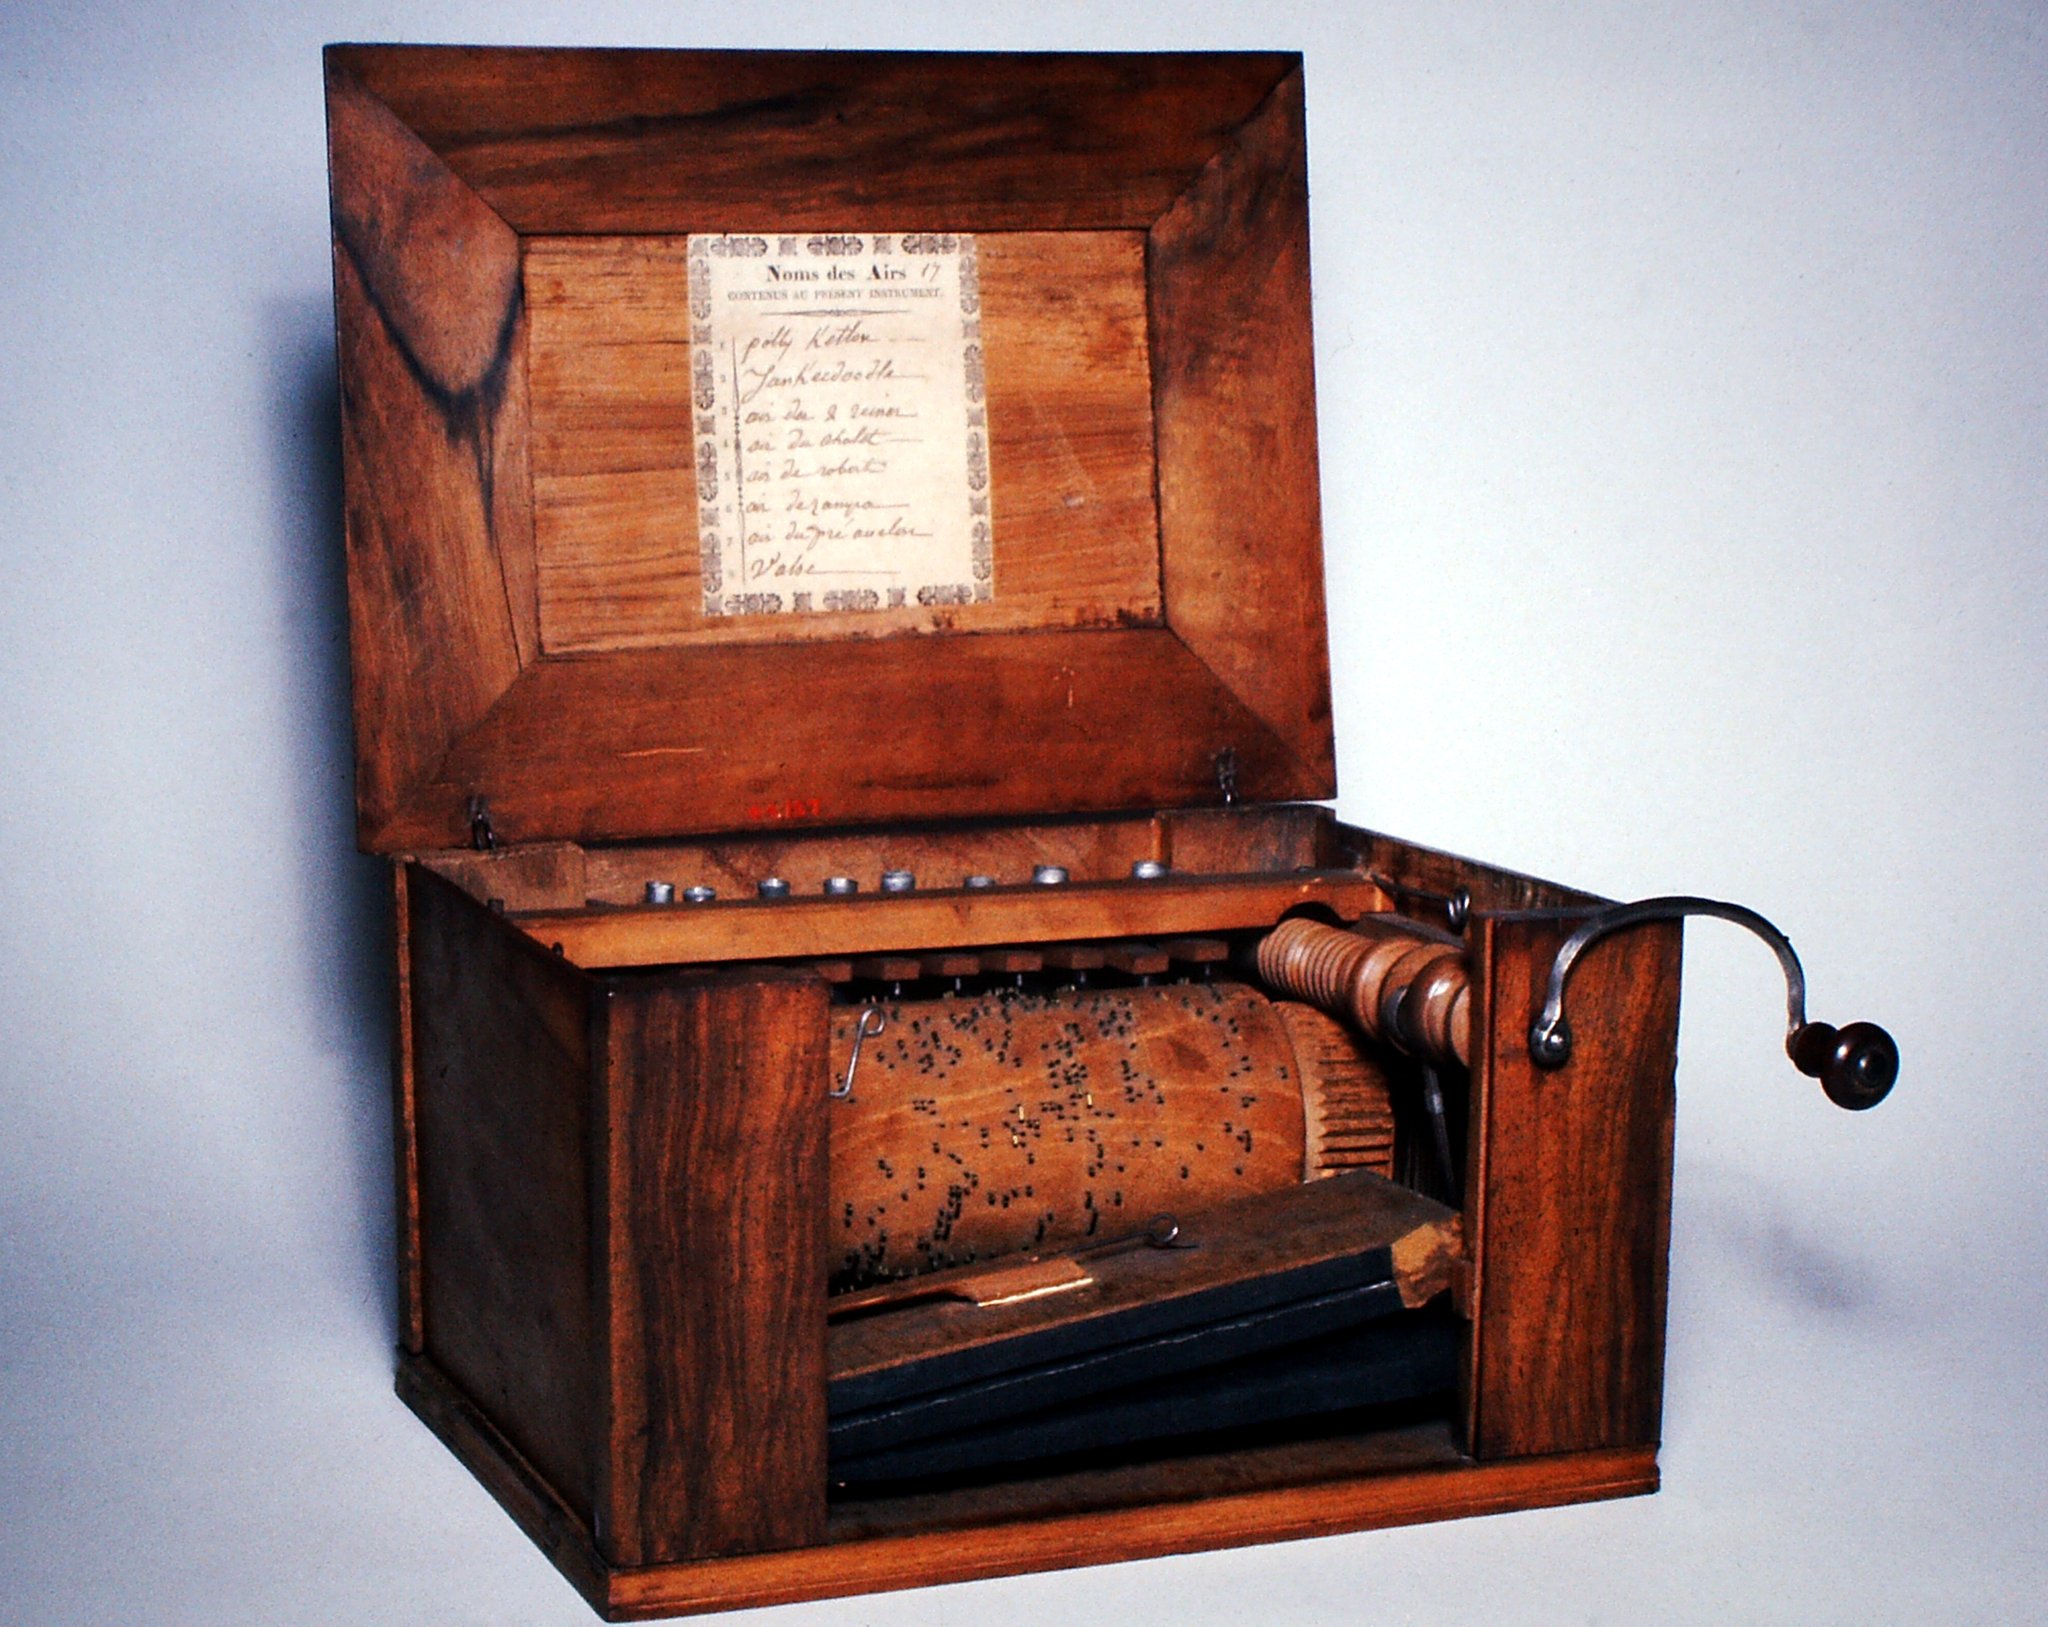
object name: serinette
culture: french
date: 1801-1833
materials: metal, wood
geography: france